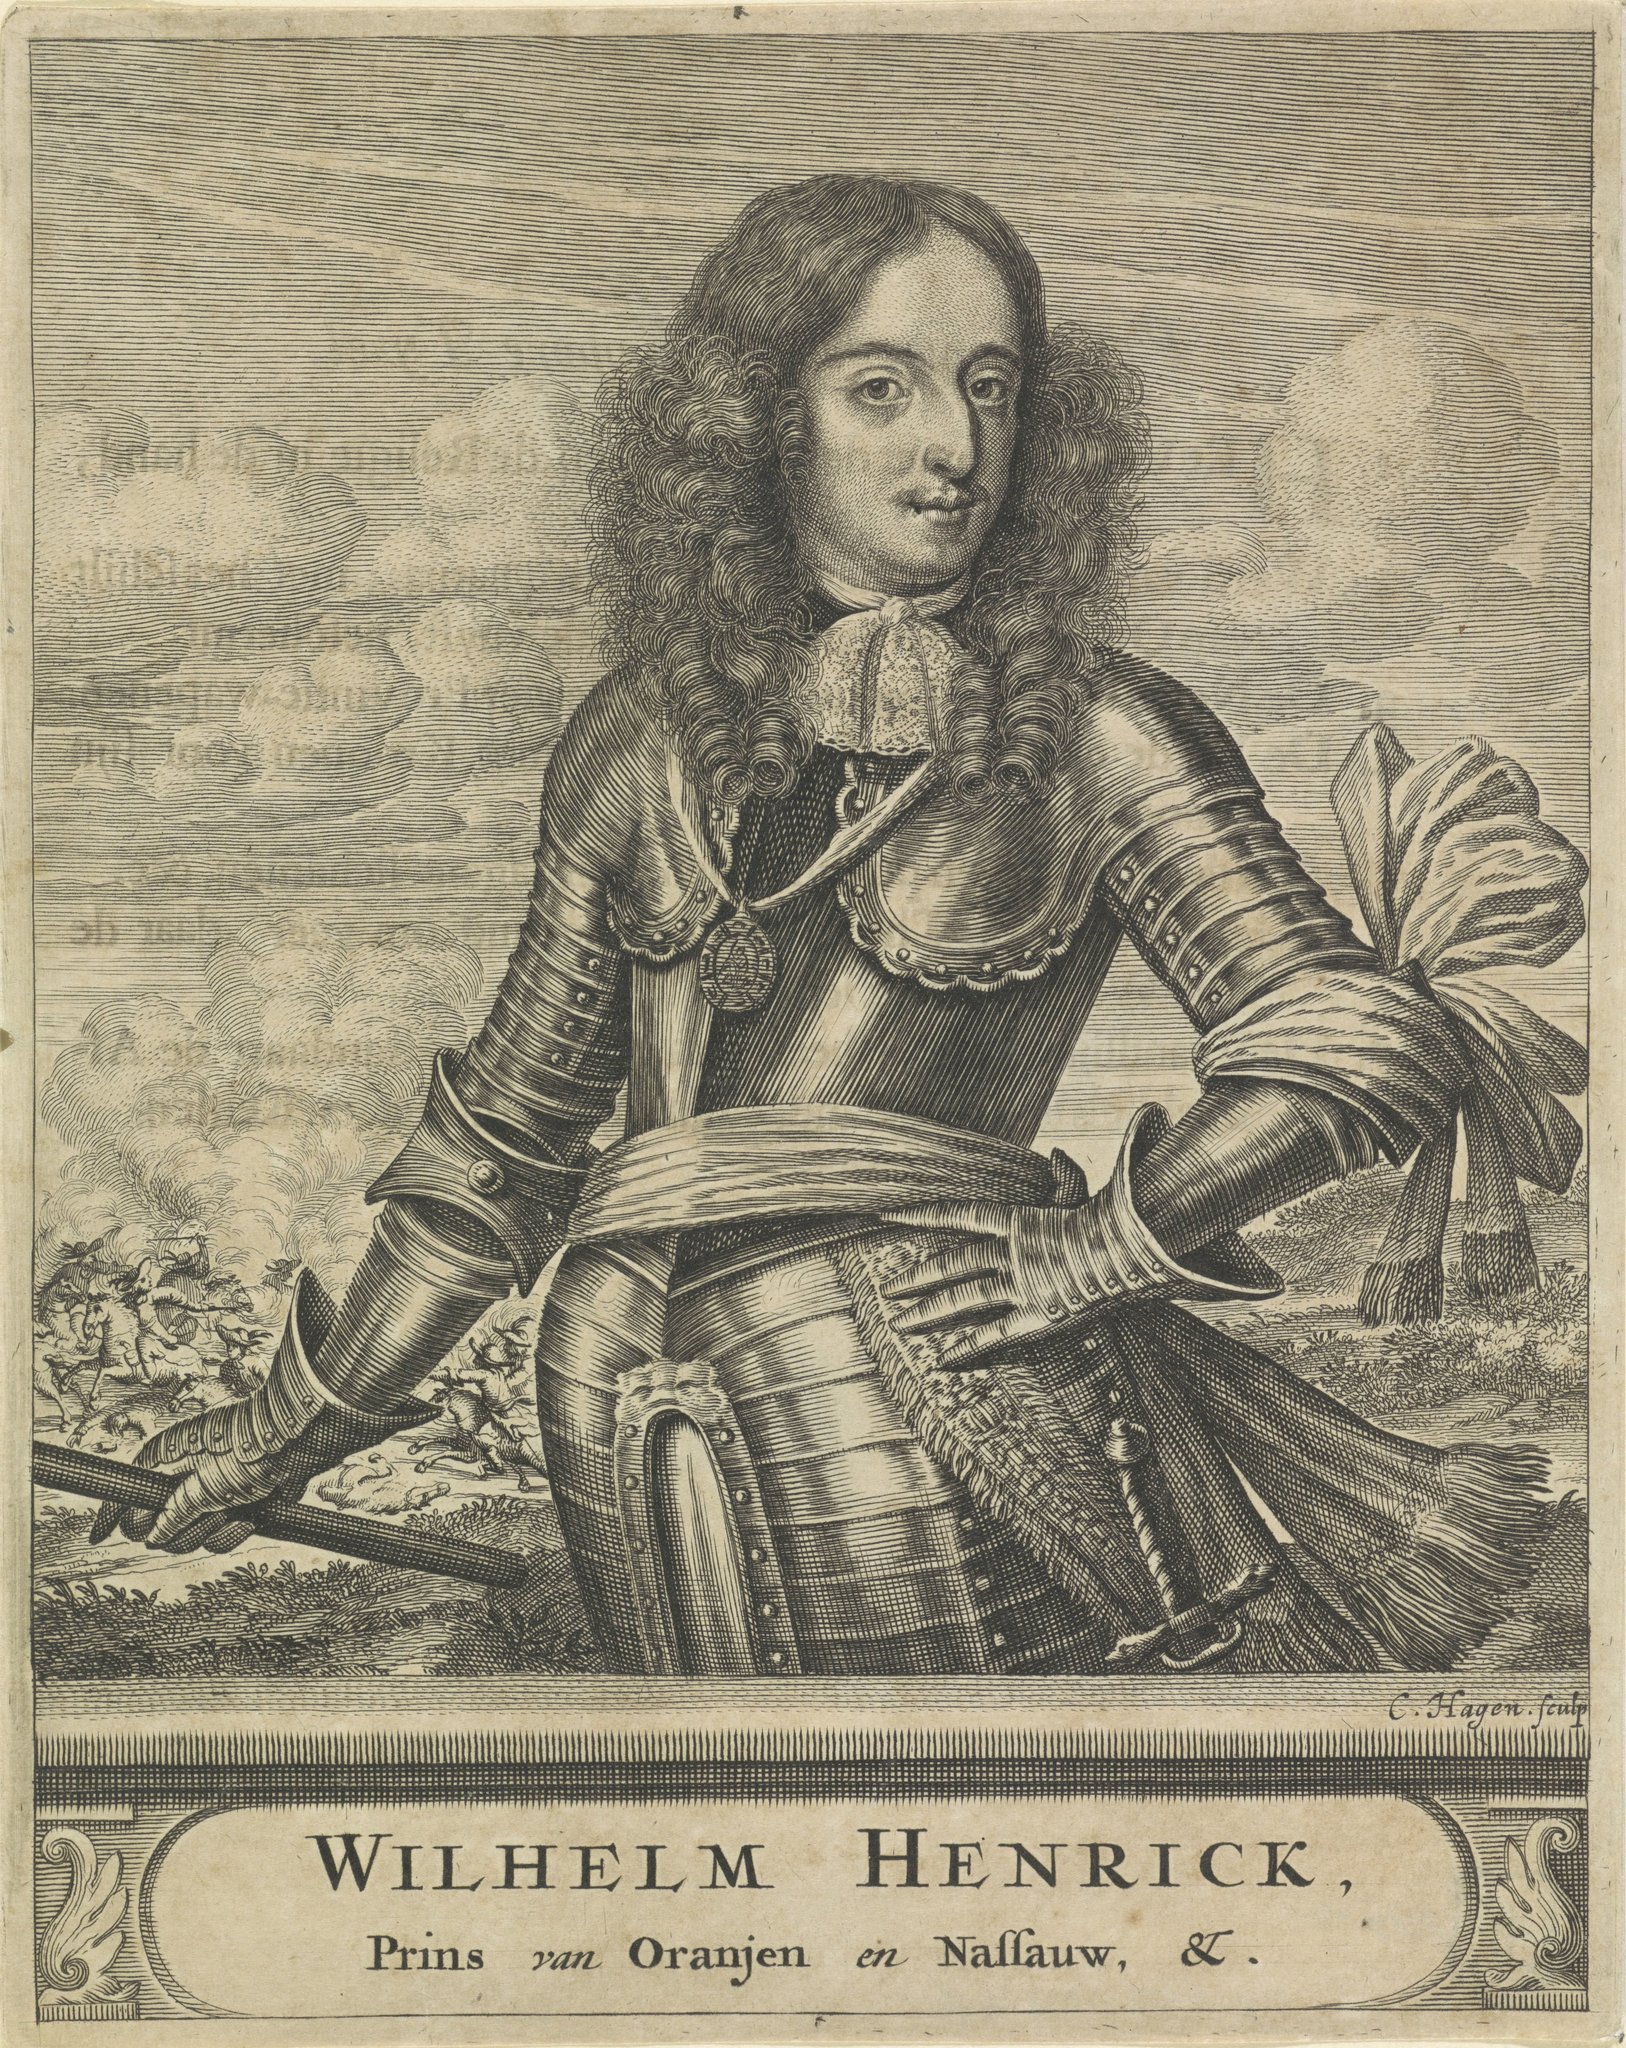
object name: print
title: Portret van Willem III, prins van Oranje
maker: christiaan hagen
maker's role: draughtsman, print maker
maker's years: 1635-1707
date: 1670-1695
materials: paper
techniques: engraving, etching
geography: amsterdam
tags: the hague, william iii (prince of orange and king of england, scotland, and ireland), knighthood order (garter) - insignia of a knighthood order, e.g.: badge, chain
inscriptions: collector's mark: Lugt 963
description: De hier vermelde titel verwijst naar de hoogst verkregen titel van de geportretteerde, niet per se naar de titel die de geportretteerde op deze voorstelling draagt.